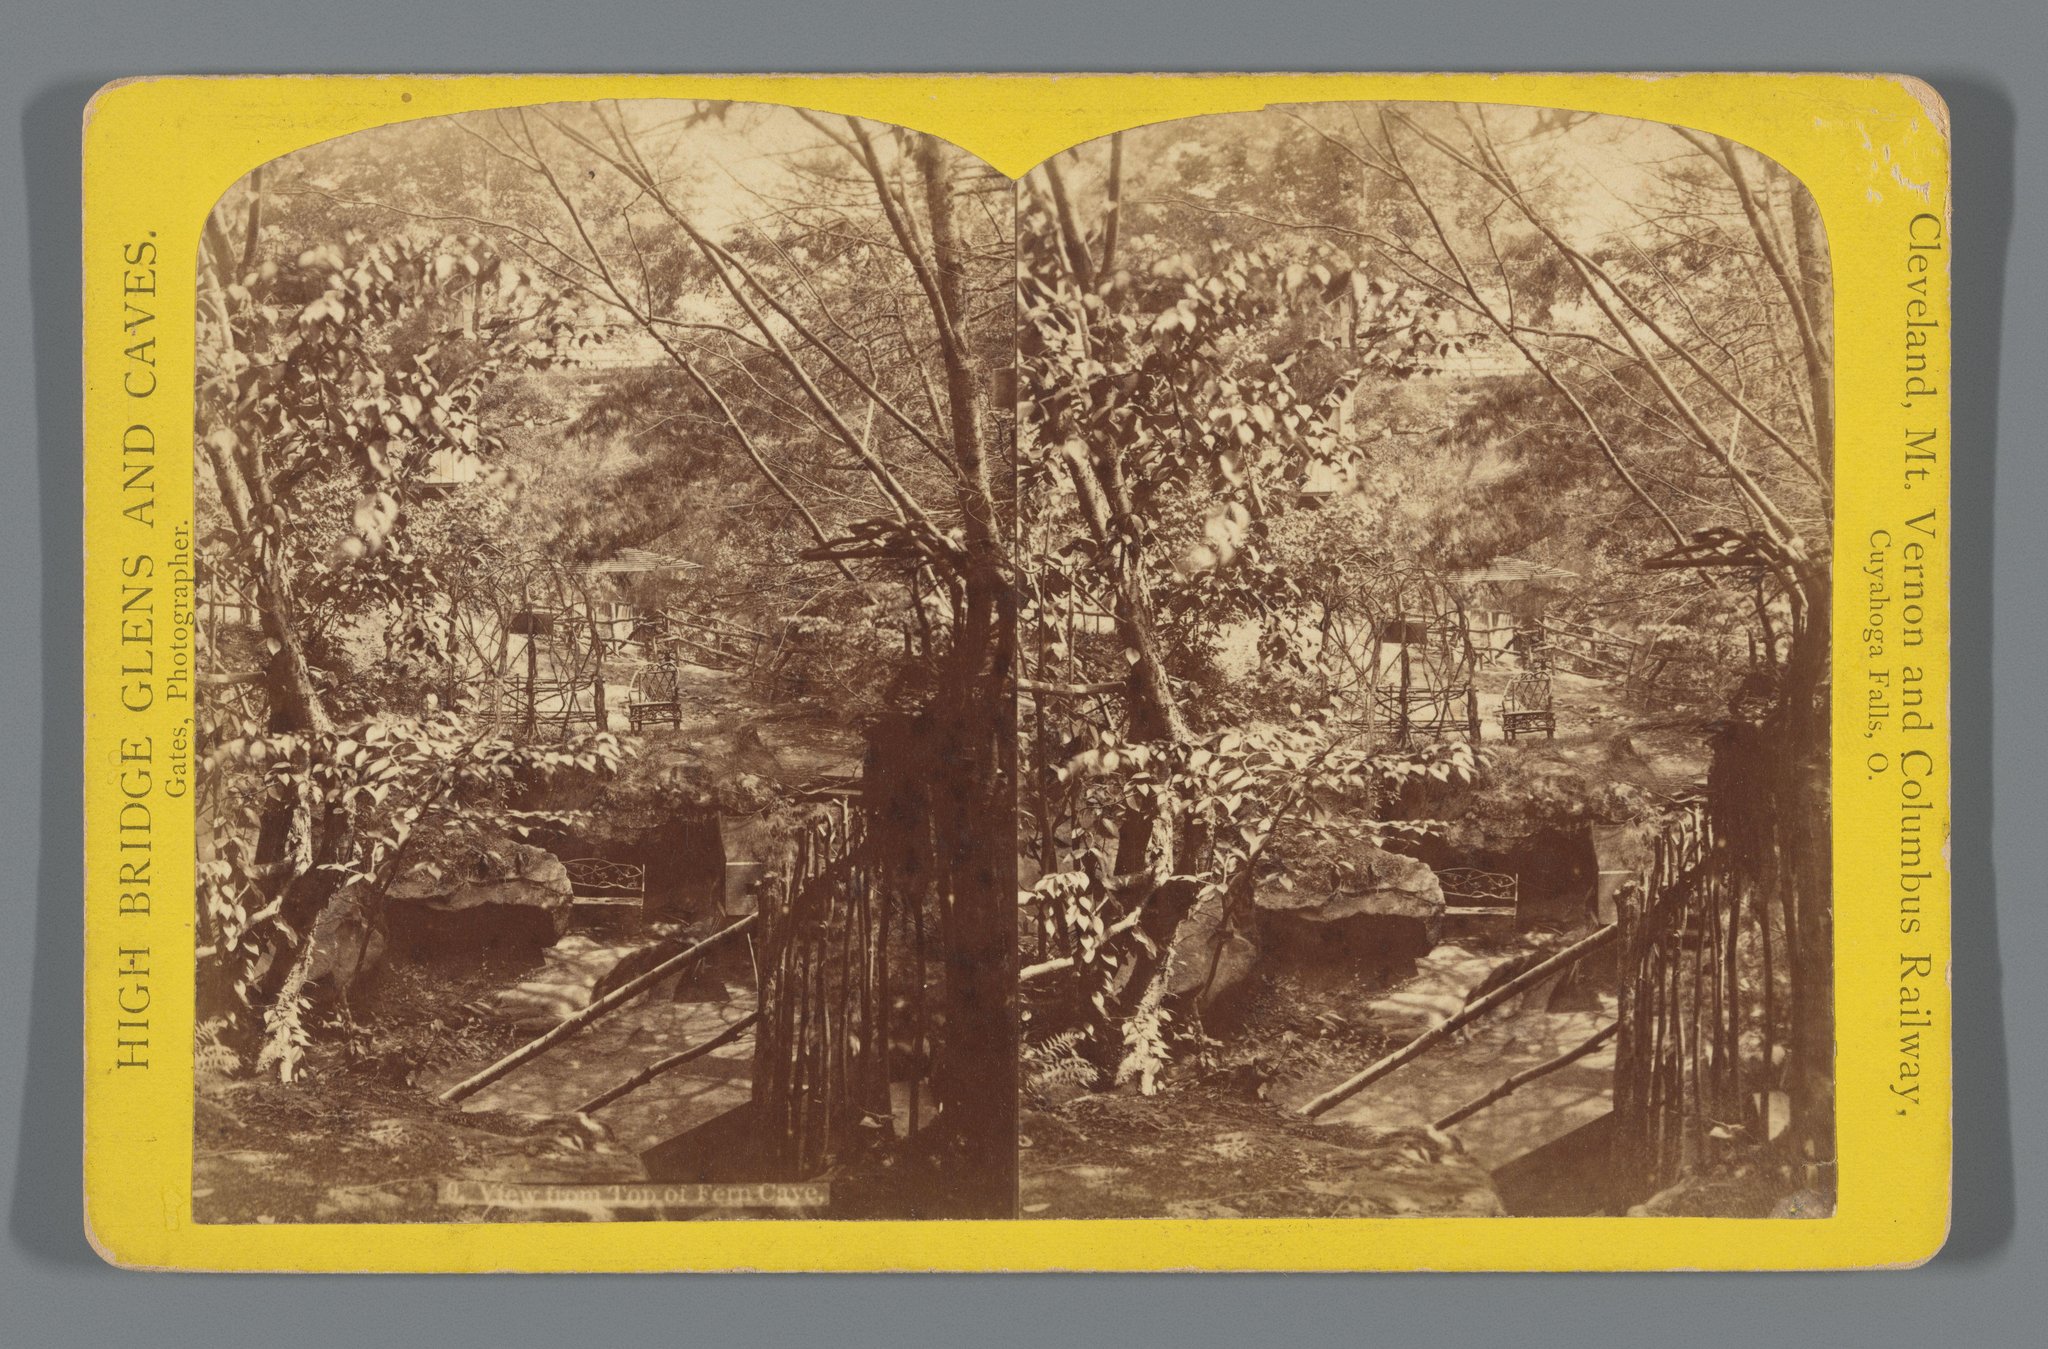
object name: photograph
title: View from Top of Fern Cave/ Lovers' Retreat, South of Cave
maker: george f. gates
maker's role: fotograaf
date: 1870-1890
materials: cardboard, photographic support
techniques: albumen print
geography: ohio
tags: forest, wood, cave, grotto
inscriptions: inscription: ‘(...)’